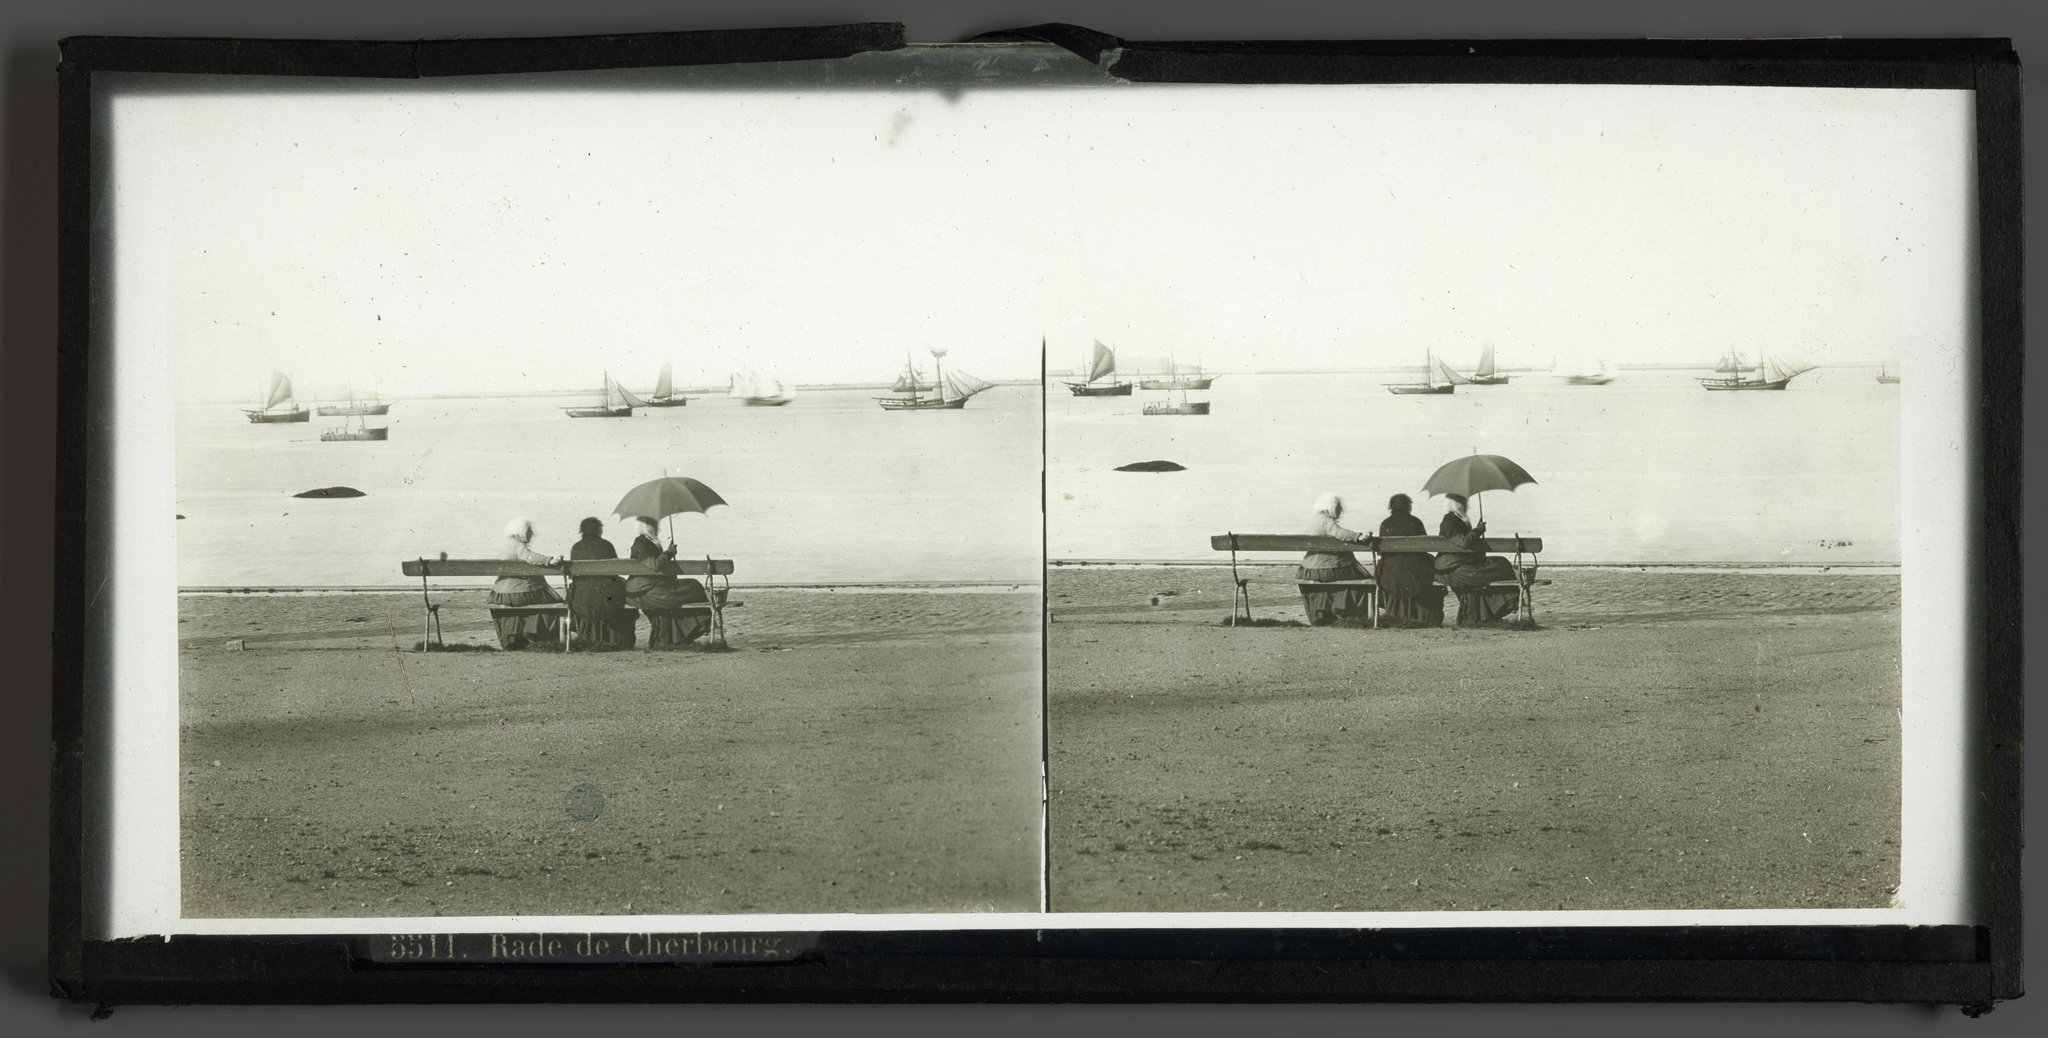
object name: stereoscopic photograph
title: Rade de Cherbourg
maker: Anonymous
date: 1860-1890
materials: glass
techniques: slide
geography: cherbourg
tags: quay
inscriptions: number: ‘5511’